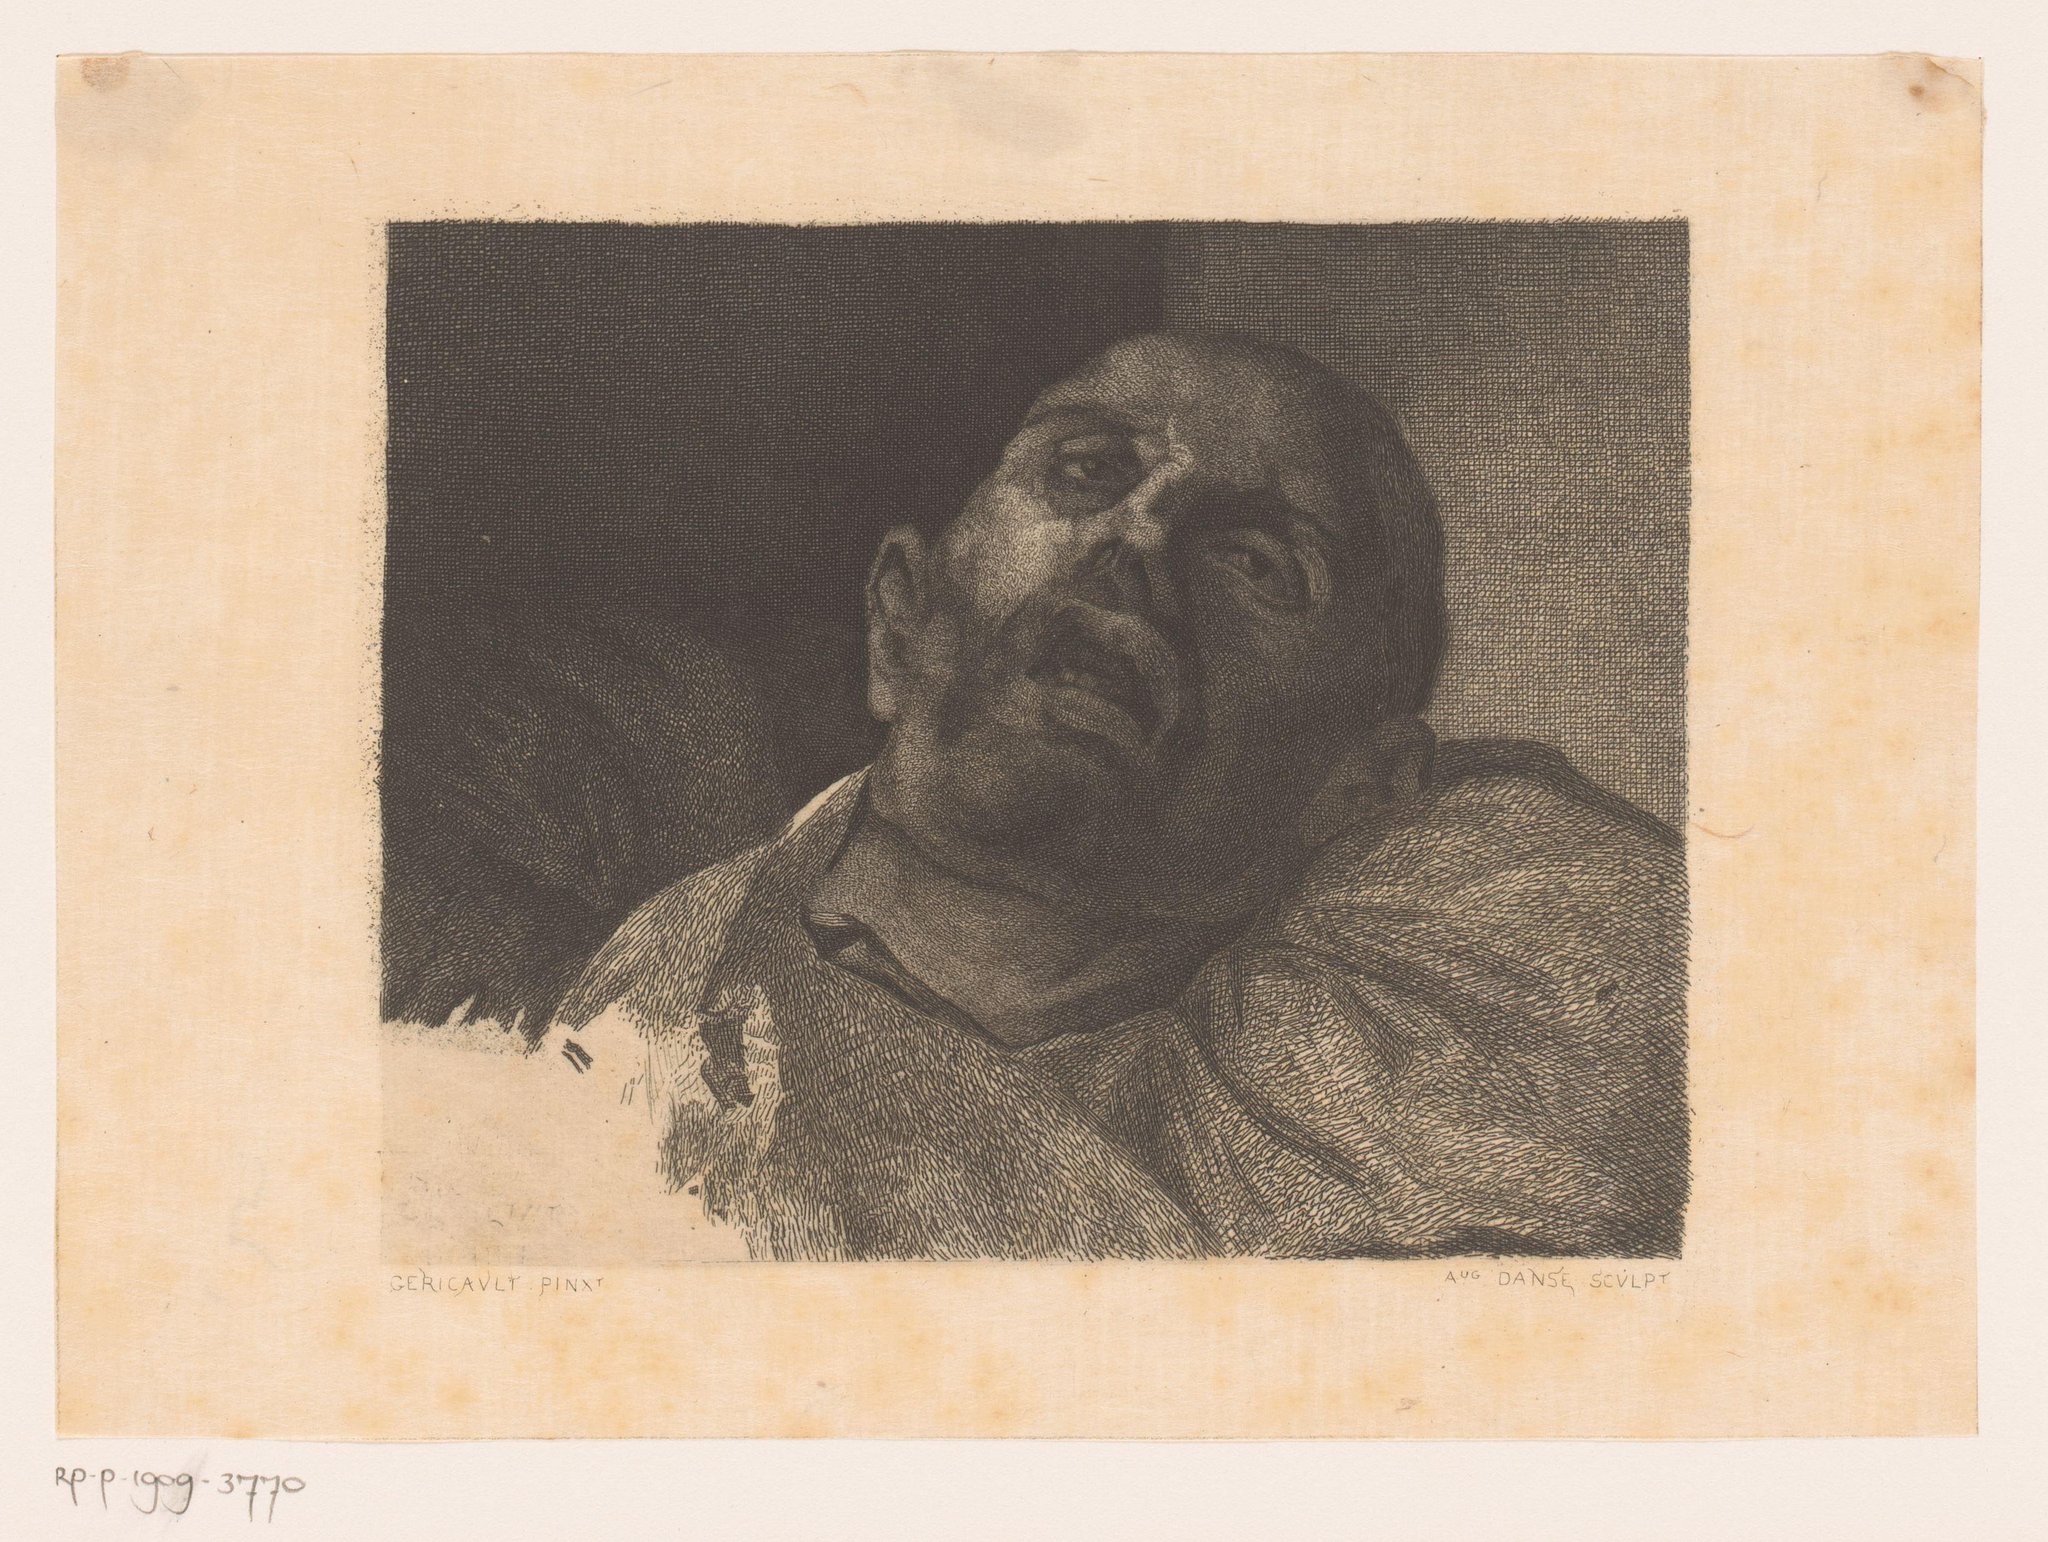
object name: print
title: Hoofd van een onthoofde man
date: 1864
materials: paper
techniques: etching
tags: head of a beheaded person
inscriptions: collector's mark: Lugt 2228